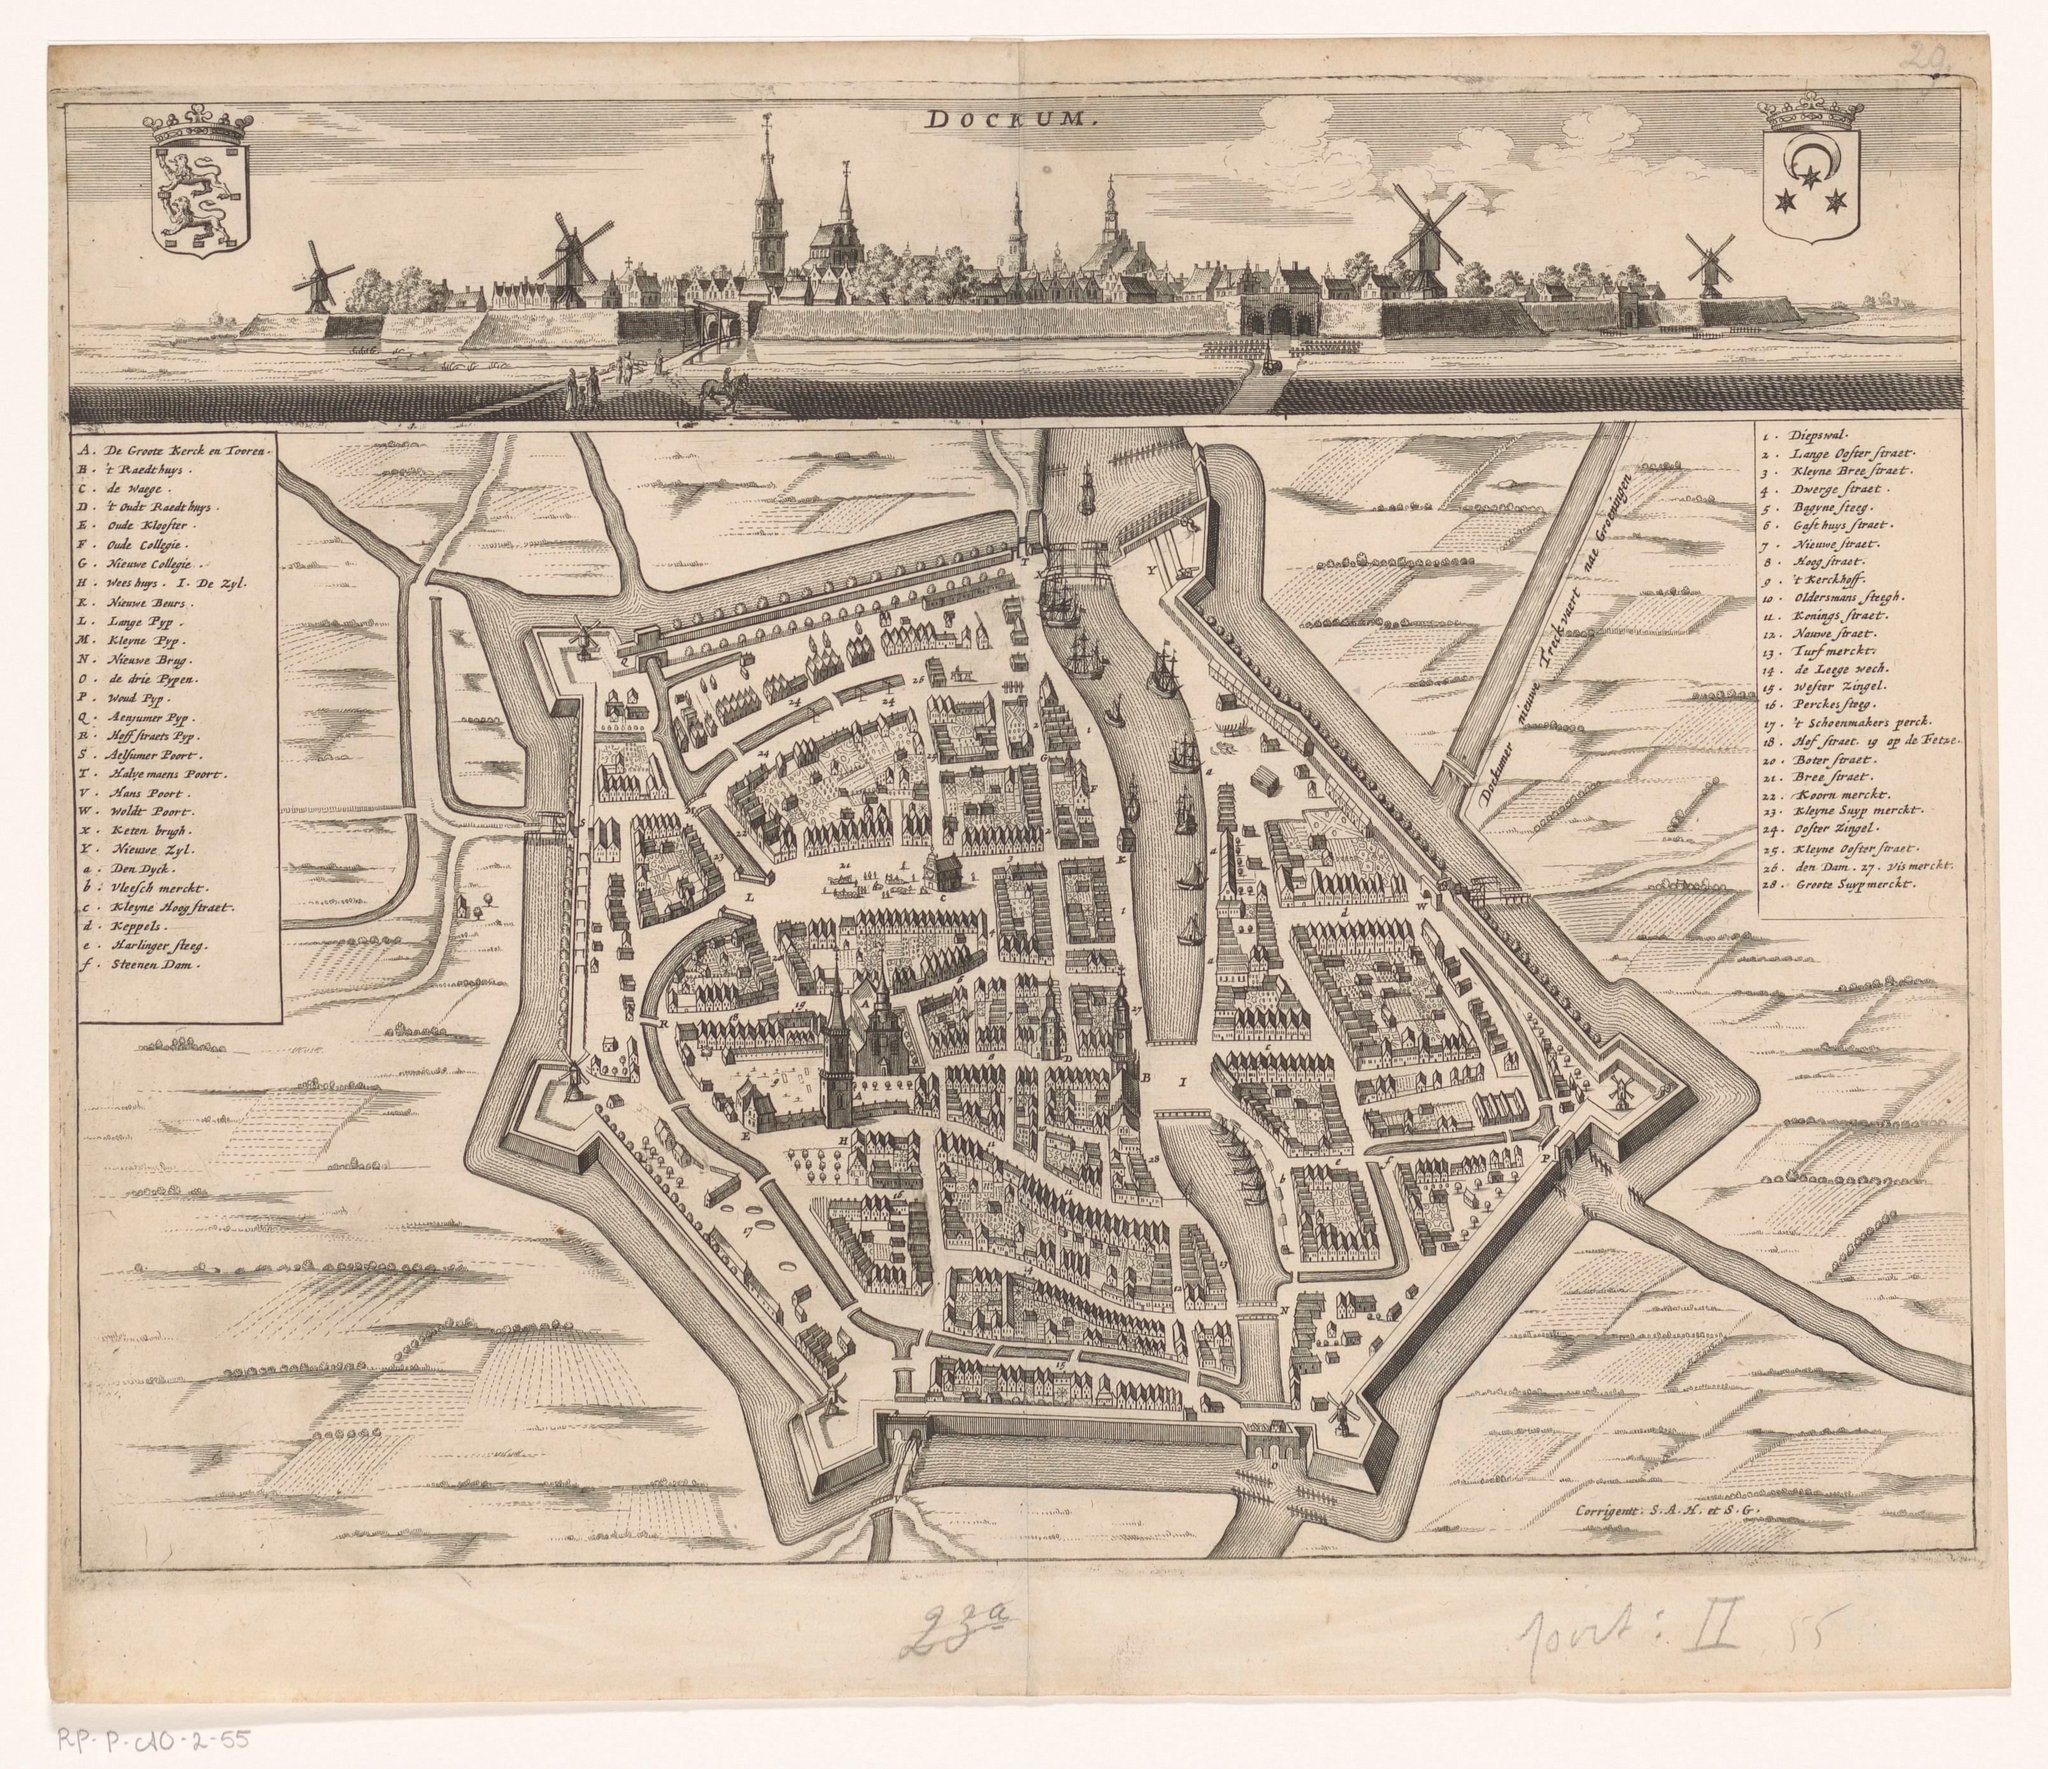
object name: print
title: Plattegrond van Dokkum met stadsgezicht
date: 1664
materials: paper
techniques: engraving, etching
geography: friesland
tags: coat of arms (as symbol of the state, etc.), city-view, and landscape with man-made constructions, maps of cities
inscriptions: collector's mark: Lugt 2228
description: Bovenaan een stadsgezicht van Dokkum met daarop links het wapen van Friesland en rechts dat van Dokkum. Daaronder een plattegrond van de stad in vogelvluchtperspectief. Links- en rechts legenda.